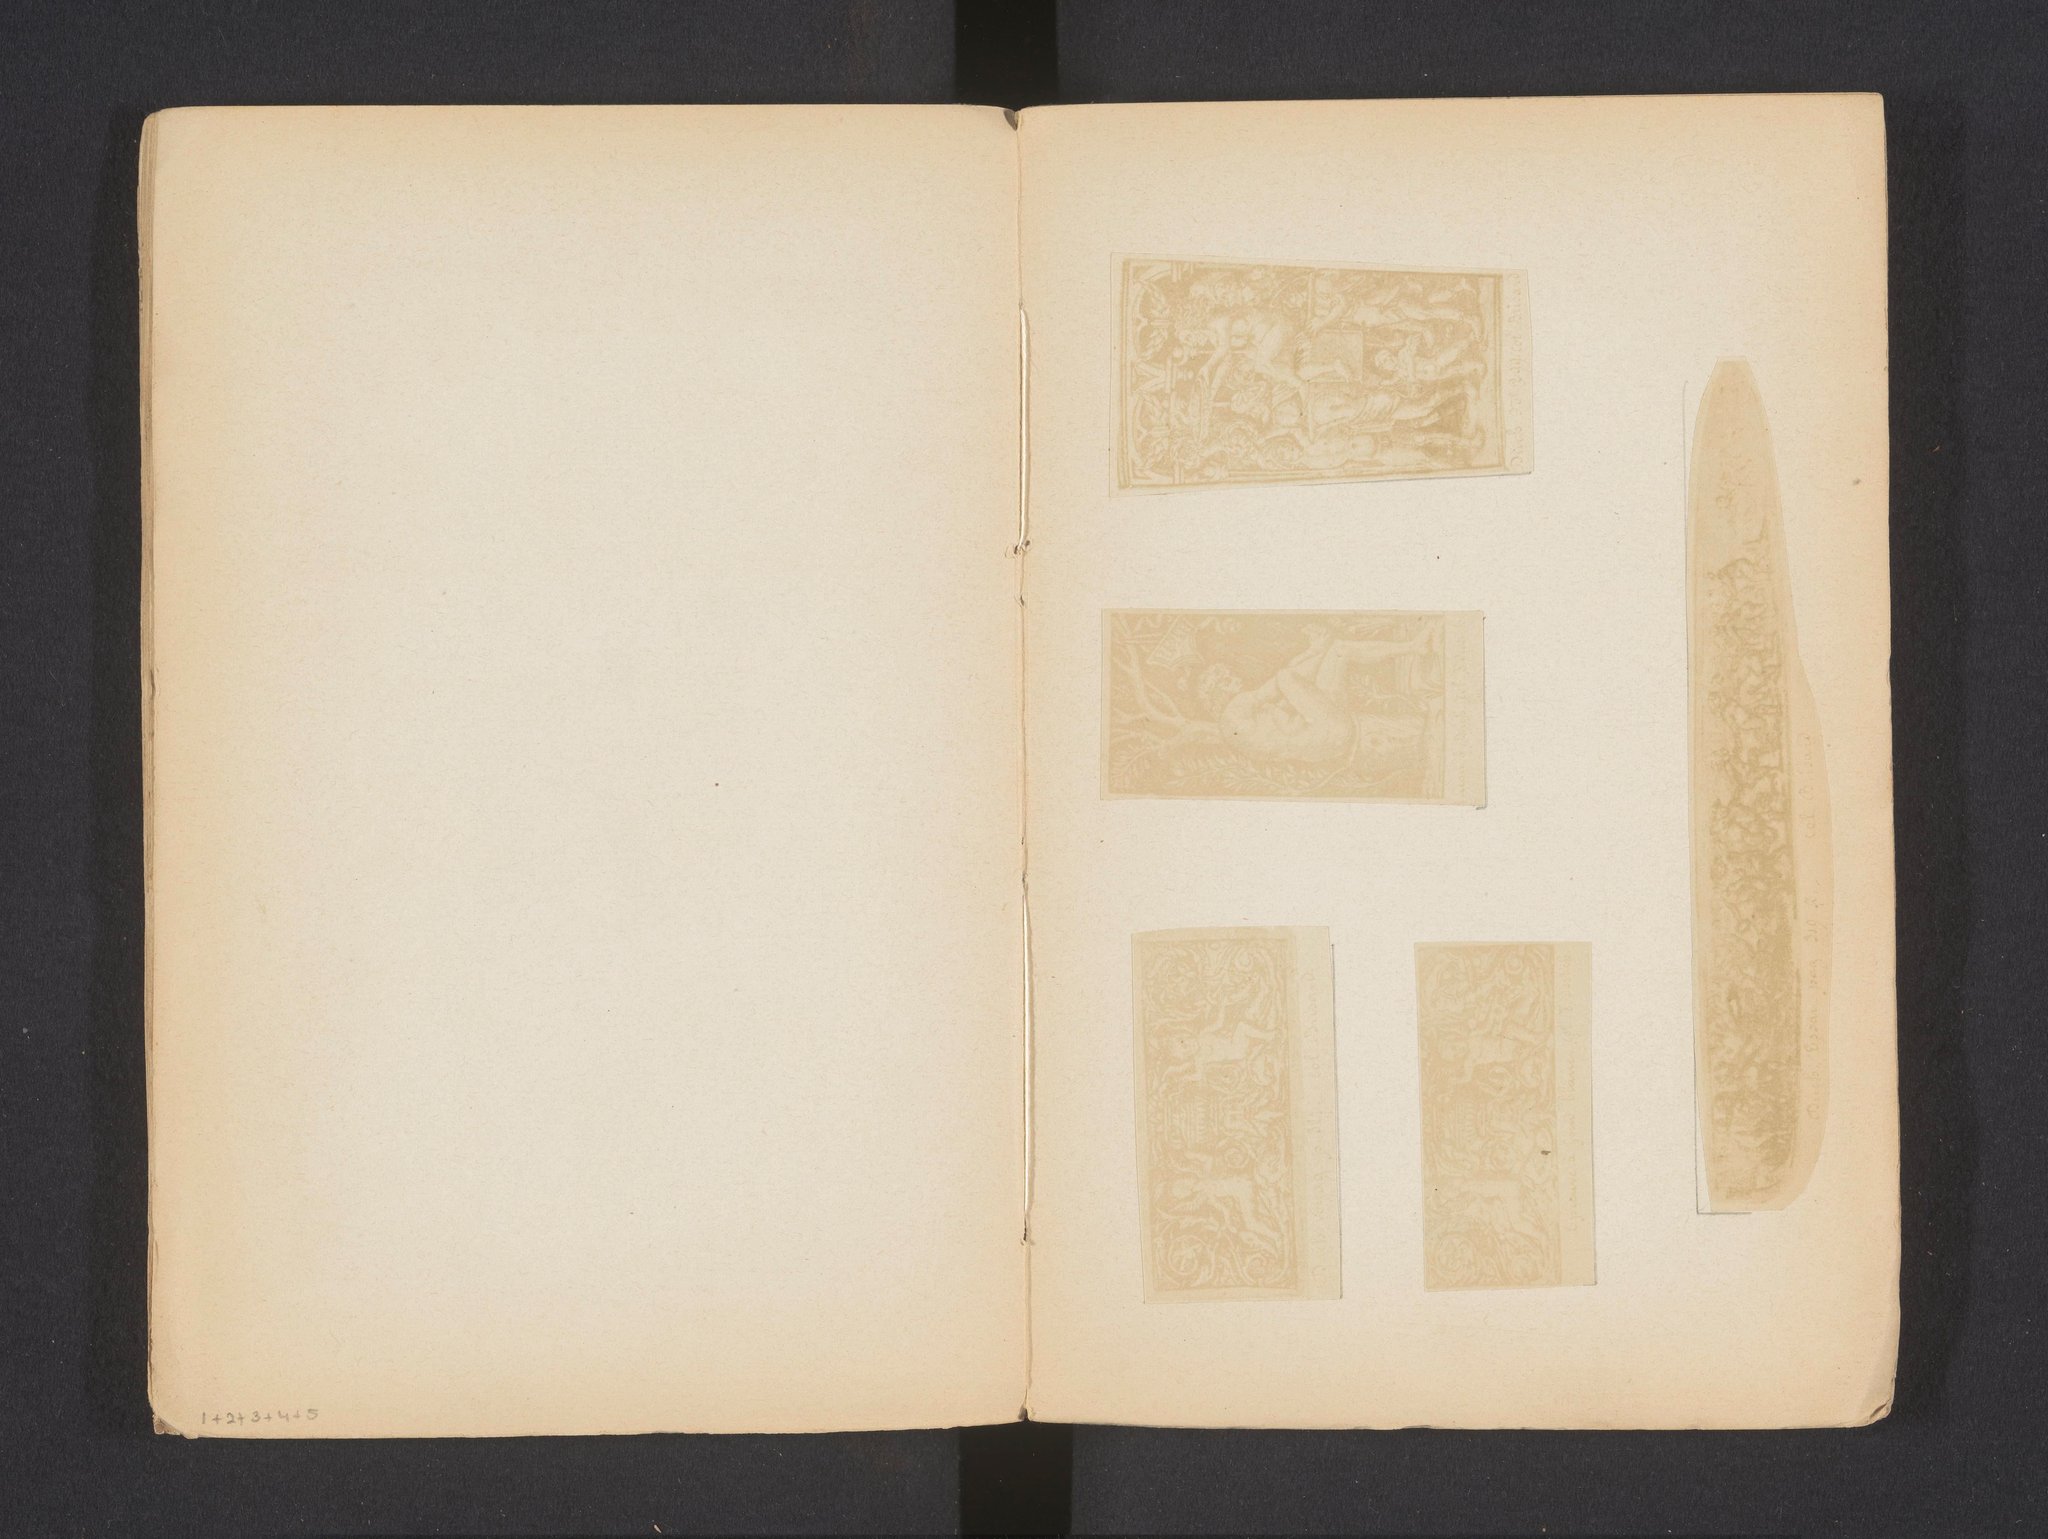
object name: page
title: Fotoreproductie van een prent van groteske ornamenten en twee putti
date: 1853-1858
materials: photographic support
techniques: salted paper print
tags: ornament ~ grotesque, cupids: 'amores', 'amoretti', 'putti'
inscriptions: inscription: ‘Duch. Voyag. p. 327. col. Brisard.’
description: Foto op derde ongenummerde pagina na pagina 142.